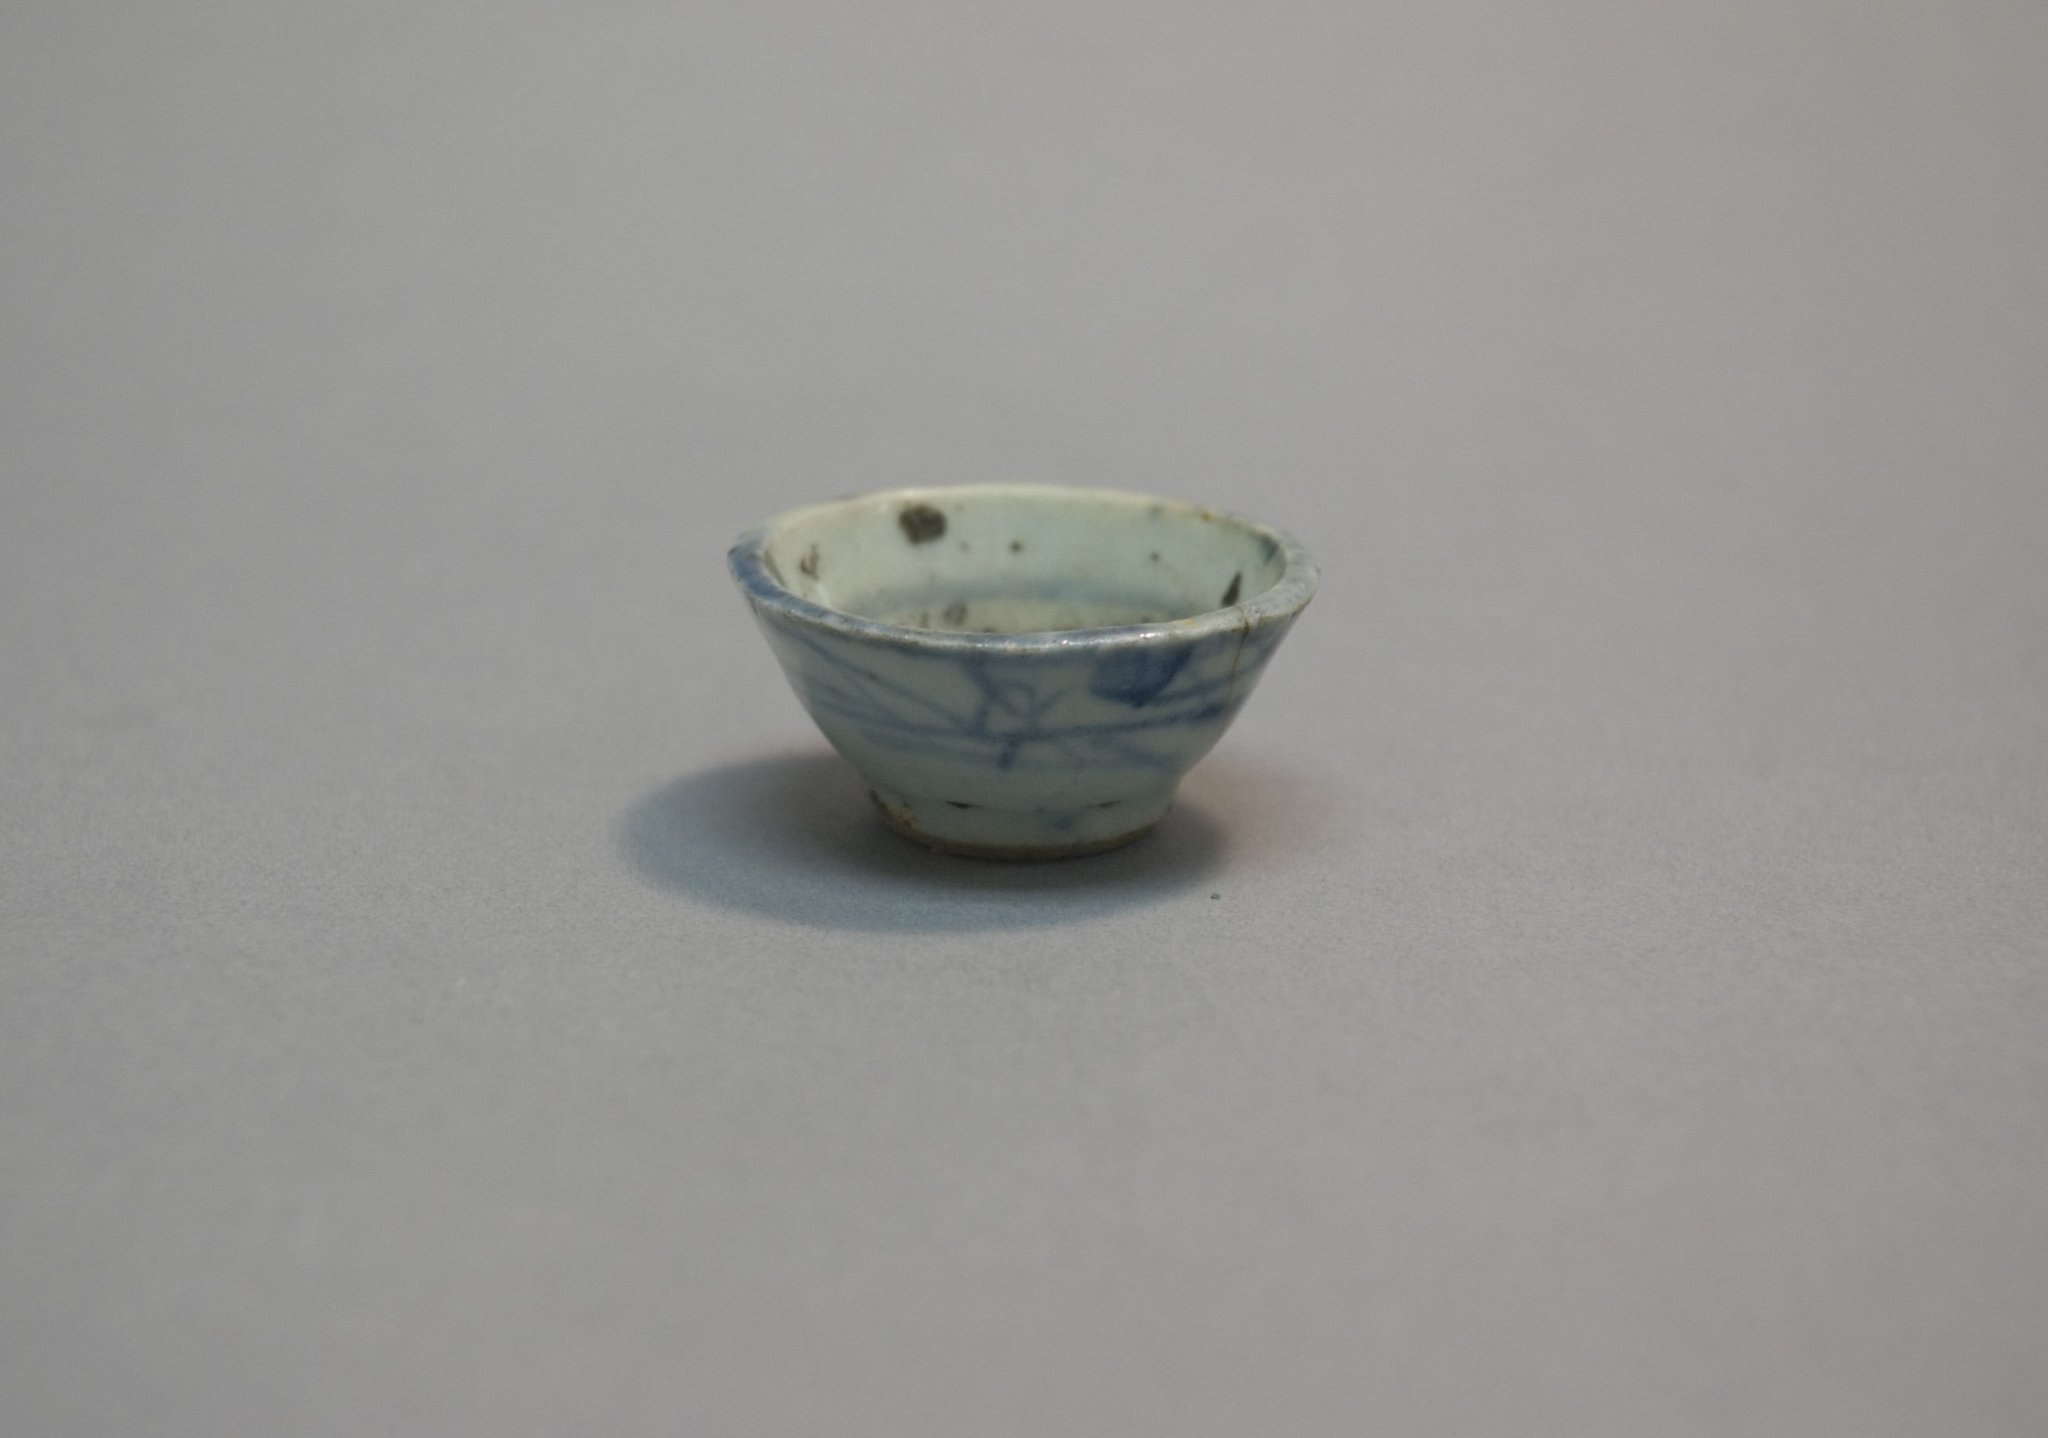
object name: jade carving tool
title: Cup for Use with Diamond-Point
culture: chinese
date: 1901-2000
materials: ceramic